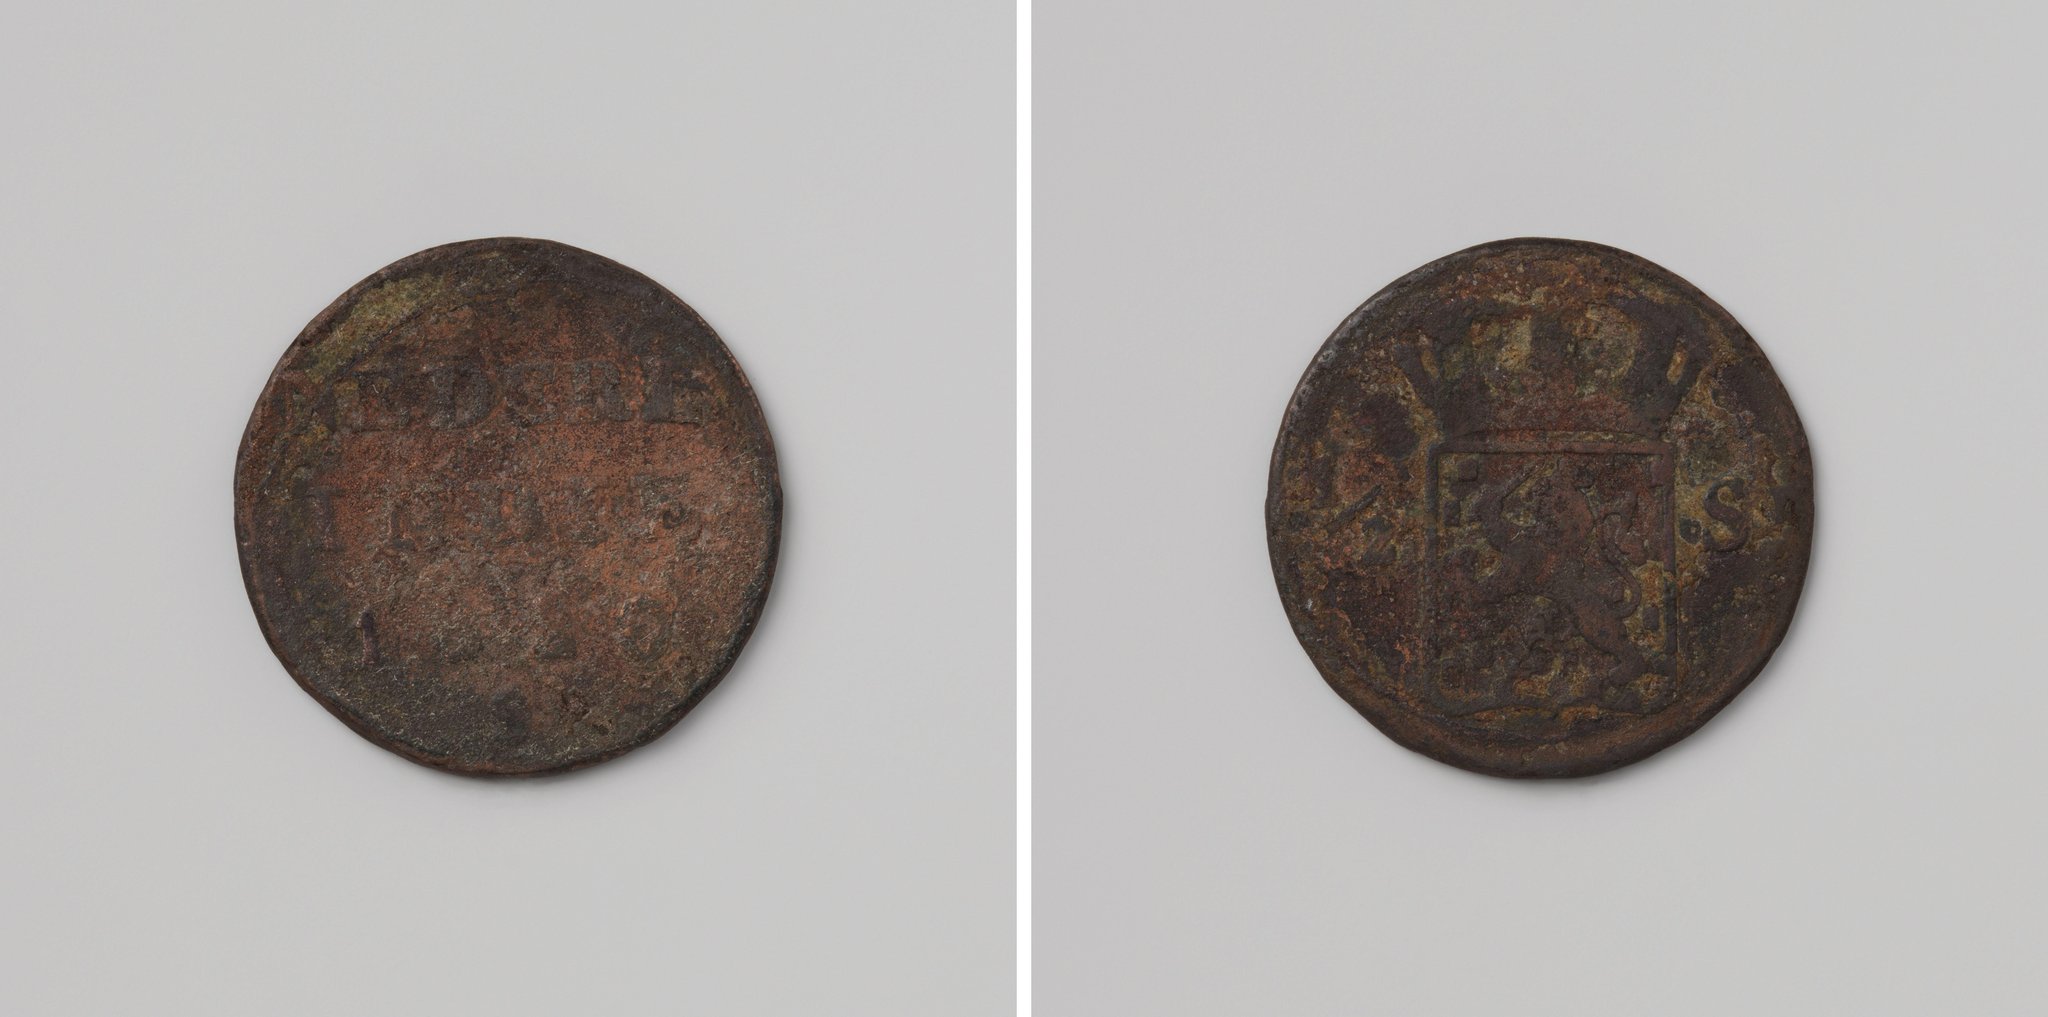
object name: coin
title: 1/2 VOC-stuiver van koper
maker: Anonymous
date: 1800-1900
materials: copper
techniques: striking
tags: dutch east indies, the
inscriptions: inscription: ‘NEDERL / INDIE / 18..6 / S’, inscription: ‘Jacques Schulman / Numismaat / Keizersgracht 448 / Amsterdam-C.’, inscription: ‘1/2 St’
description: Koperen 1/2 stuiver van de VOC uit Nederlands-Indië, waarschijnlijk uit18..6. Voorzijde: opschrift. Keerzijde: een gekroond wapen met leeuw erin en links ervan staat 1/2, rechts ervan staan de letters St. Het muntje zit in een vierkant envelopje met opschrift.